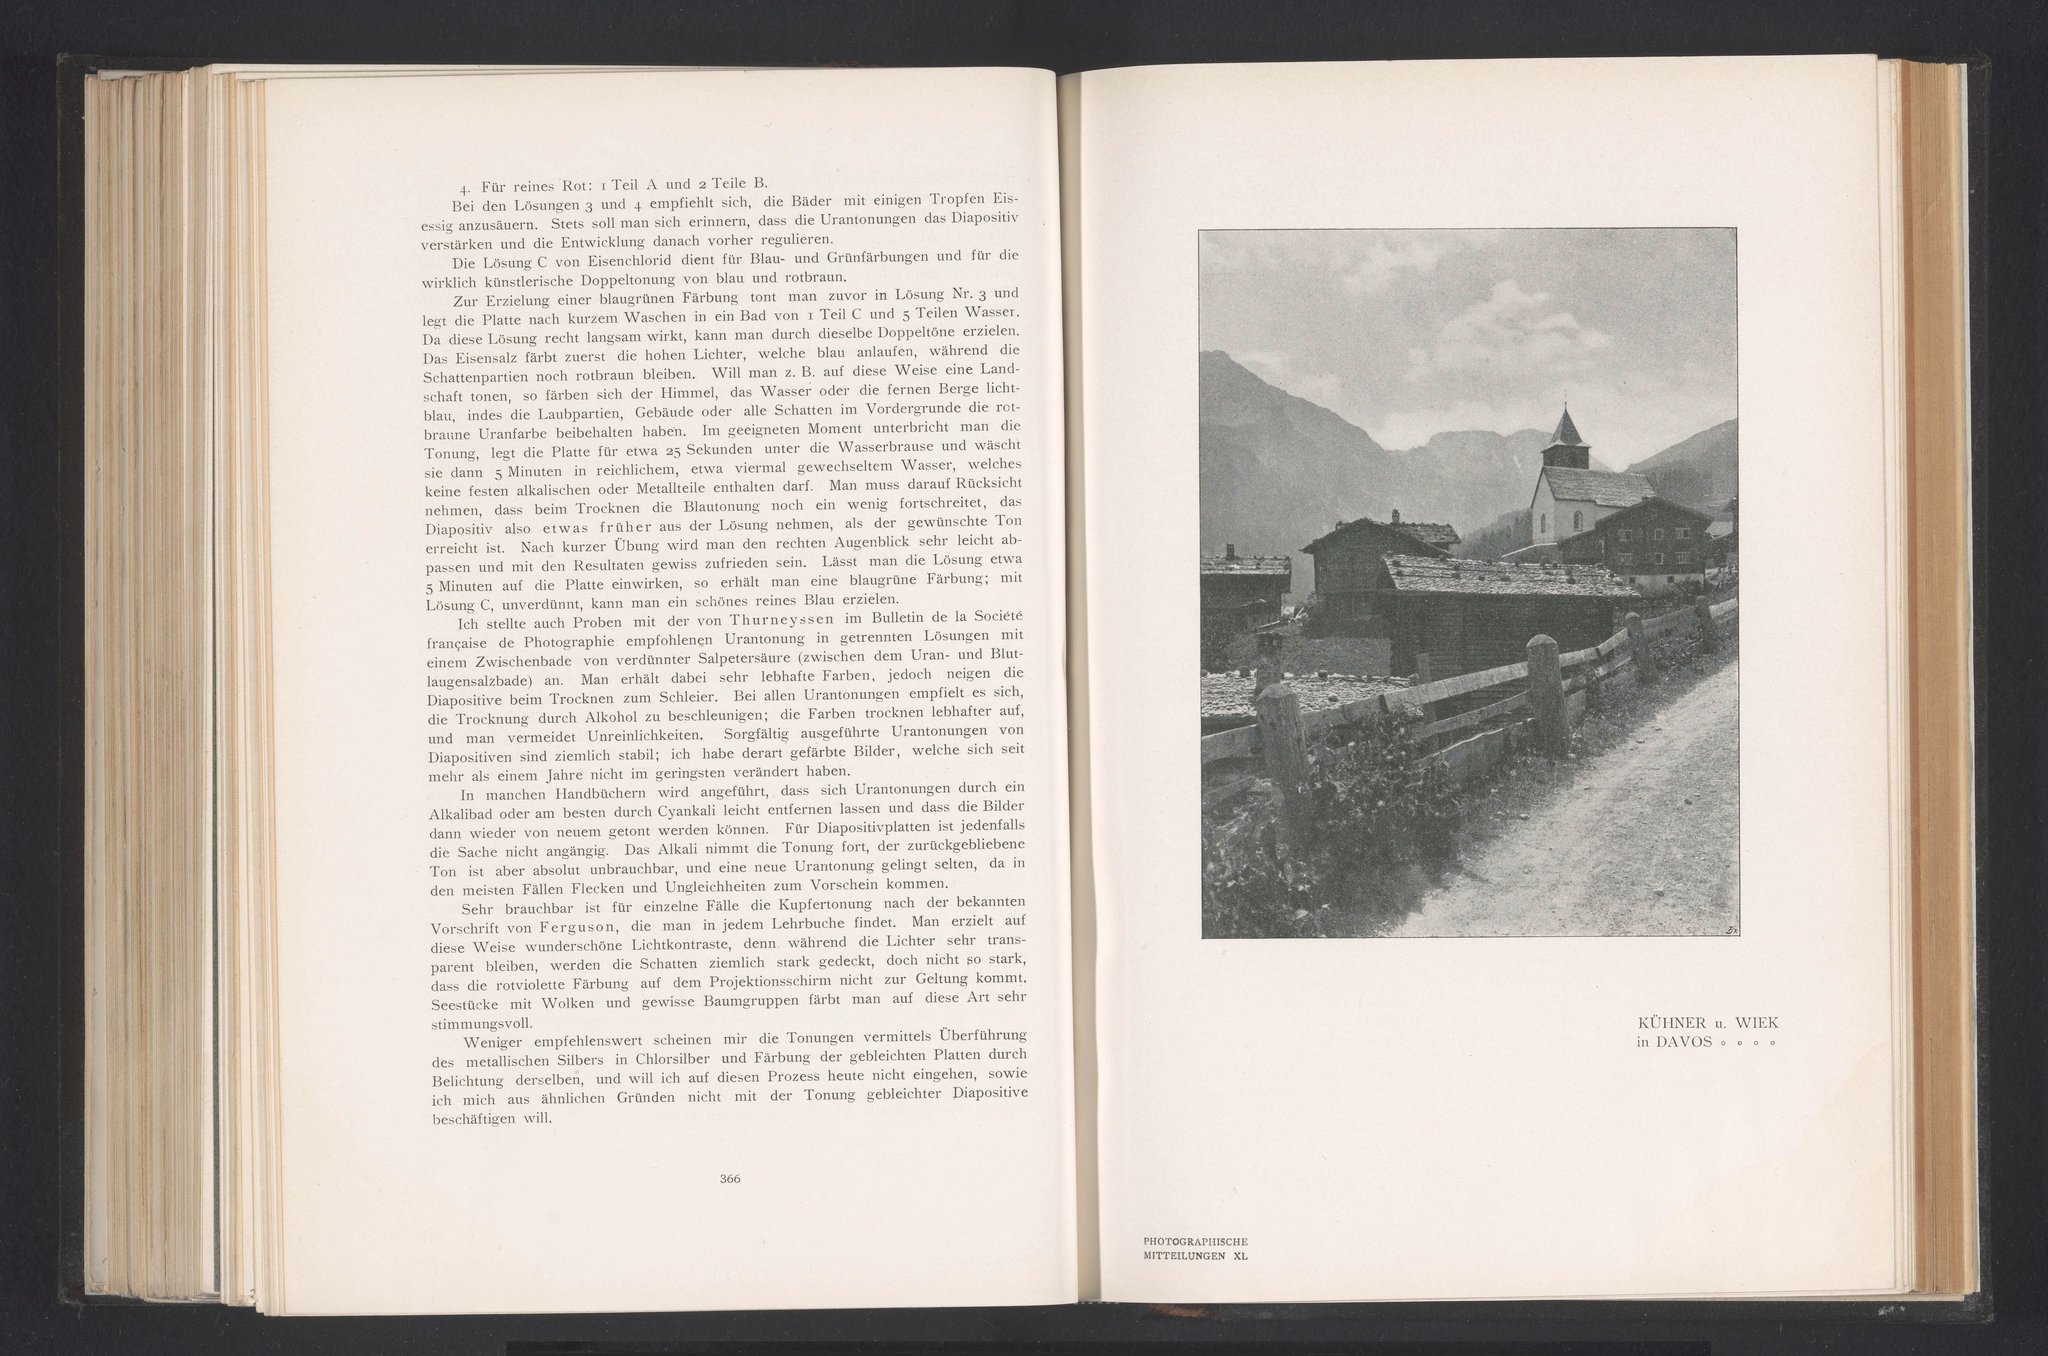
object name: page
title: Dorpsgezicht in de bergen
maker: Anonymous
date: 1898-1903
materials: paper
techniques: autotype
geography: davos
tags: village, mountains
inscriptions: monogram: ‘BX’, inscription: ‘Photographische Mitteilungen XL’